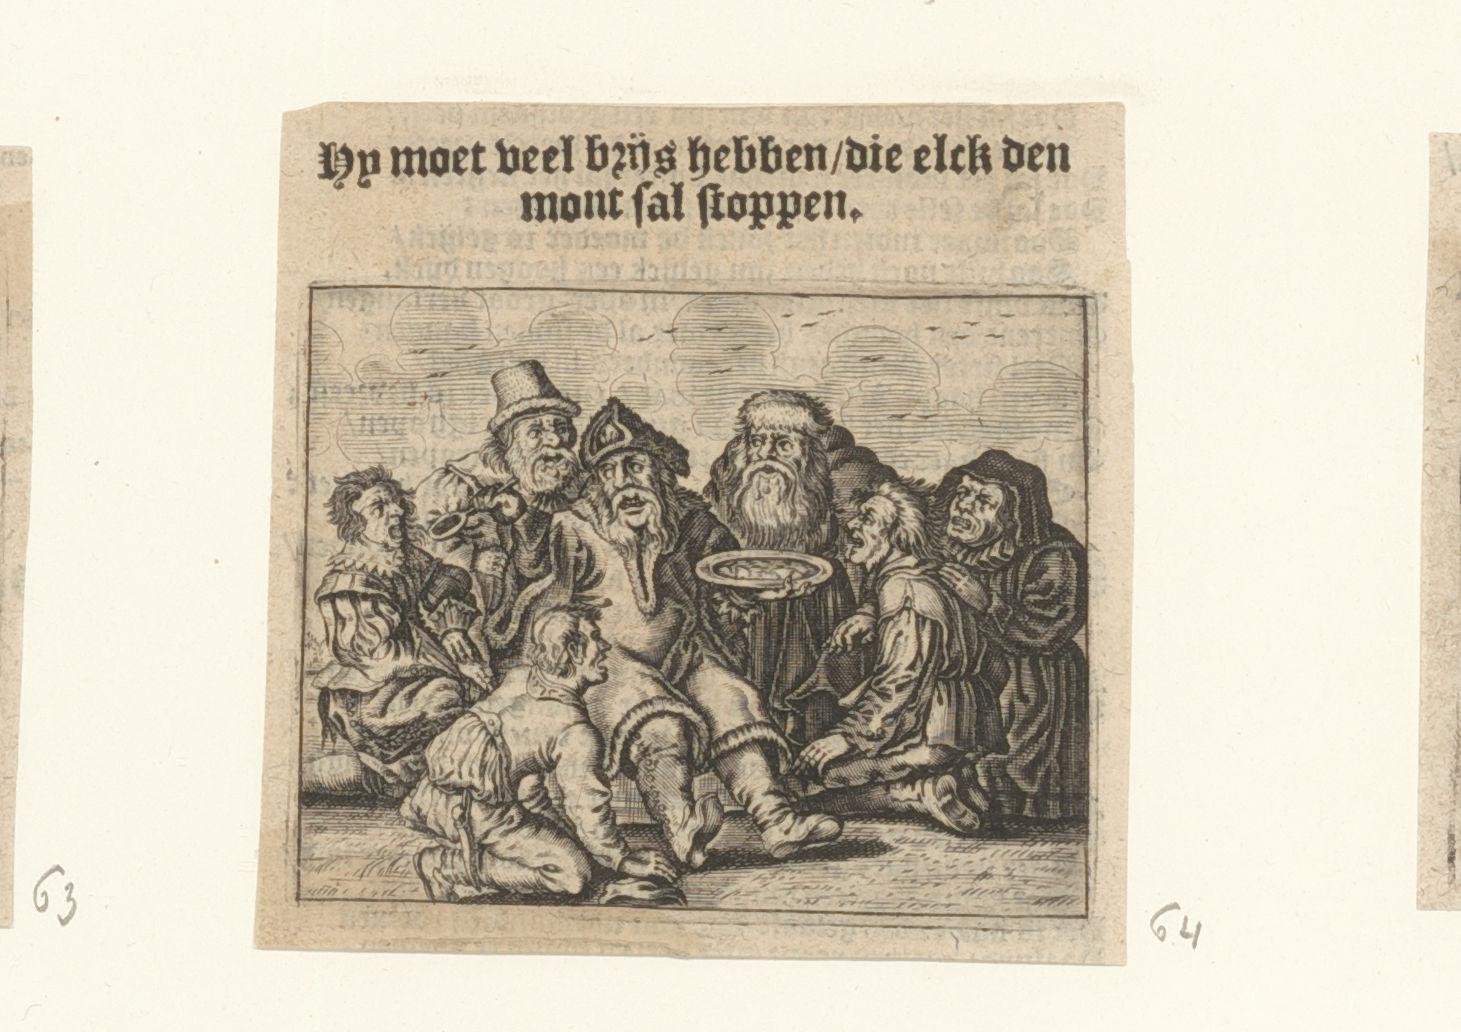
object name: book illustration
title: Groep mensen rond een bord eten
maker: Anonymous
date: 1635-1715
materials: paper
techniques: engraving, letterpress printing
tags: giving food, proverbs, sayings, etc., the poor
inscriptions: stamp, collector's mark: Lugt 1641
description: Veel versies van dit embleem verschenen in verschillende uitgave van Spiegel van den Ouden ende Nieuwen Tydt. Zoals: Cats, Jacob. Spiegel van den Ouden ende Nieuwen-tijt, Bestaende uyt Spreeck-woorden (...). Dordrecht: Jacob Braat, 1647. Maar ook in andere publicaties (1665, 1671, 1715, 1722).